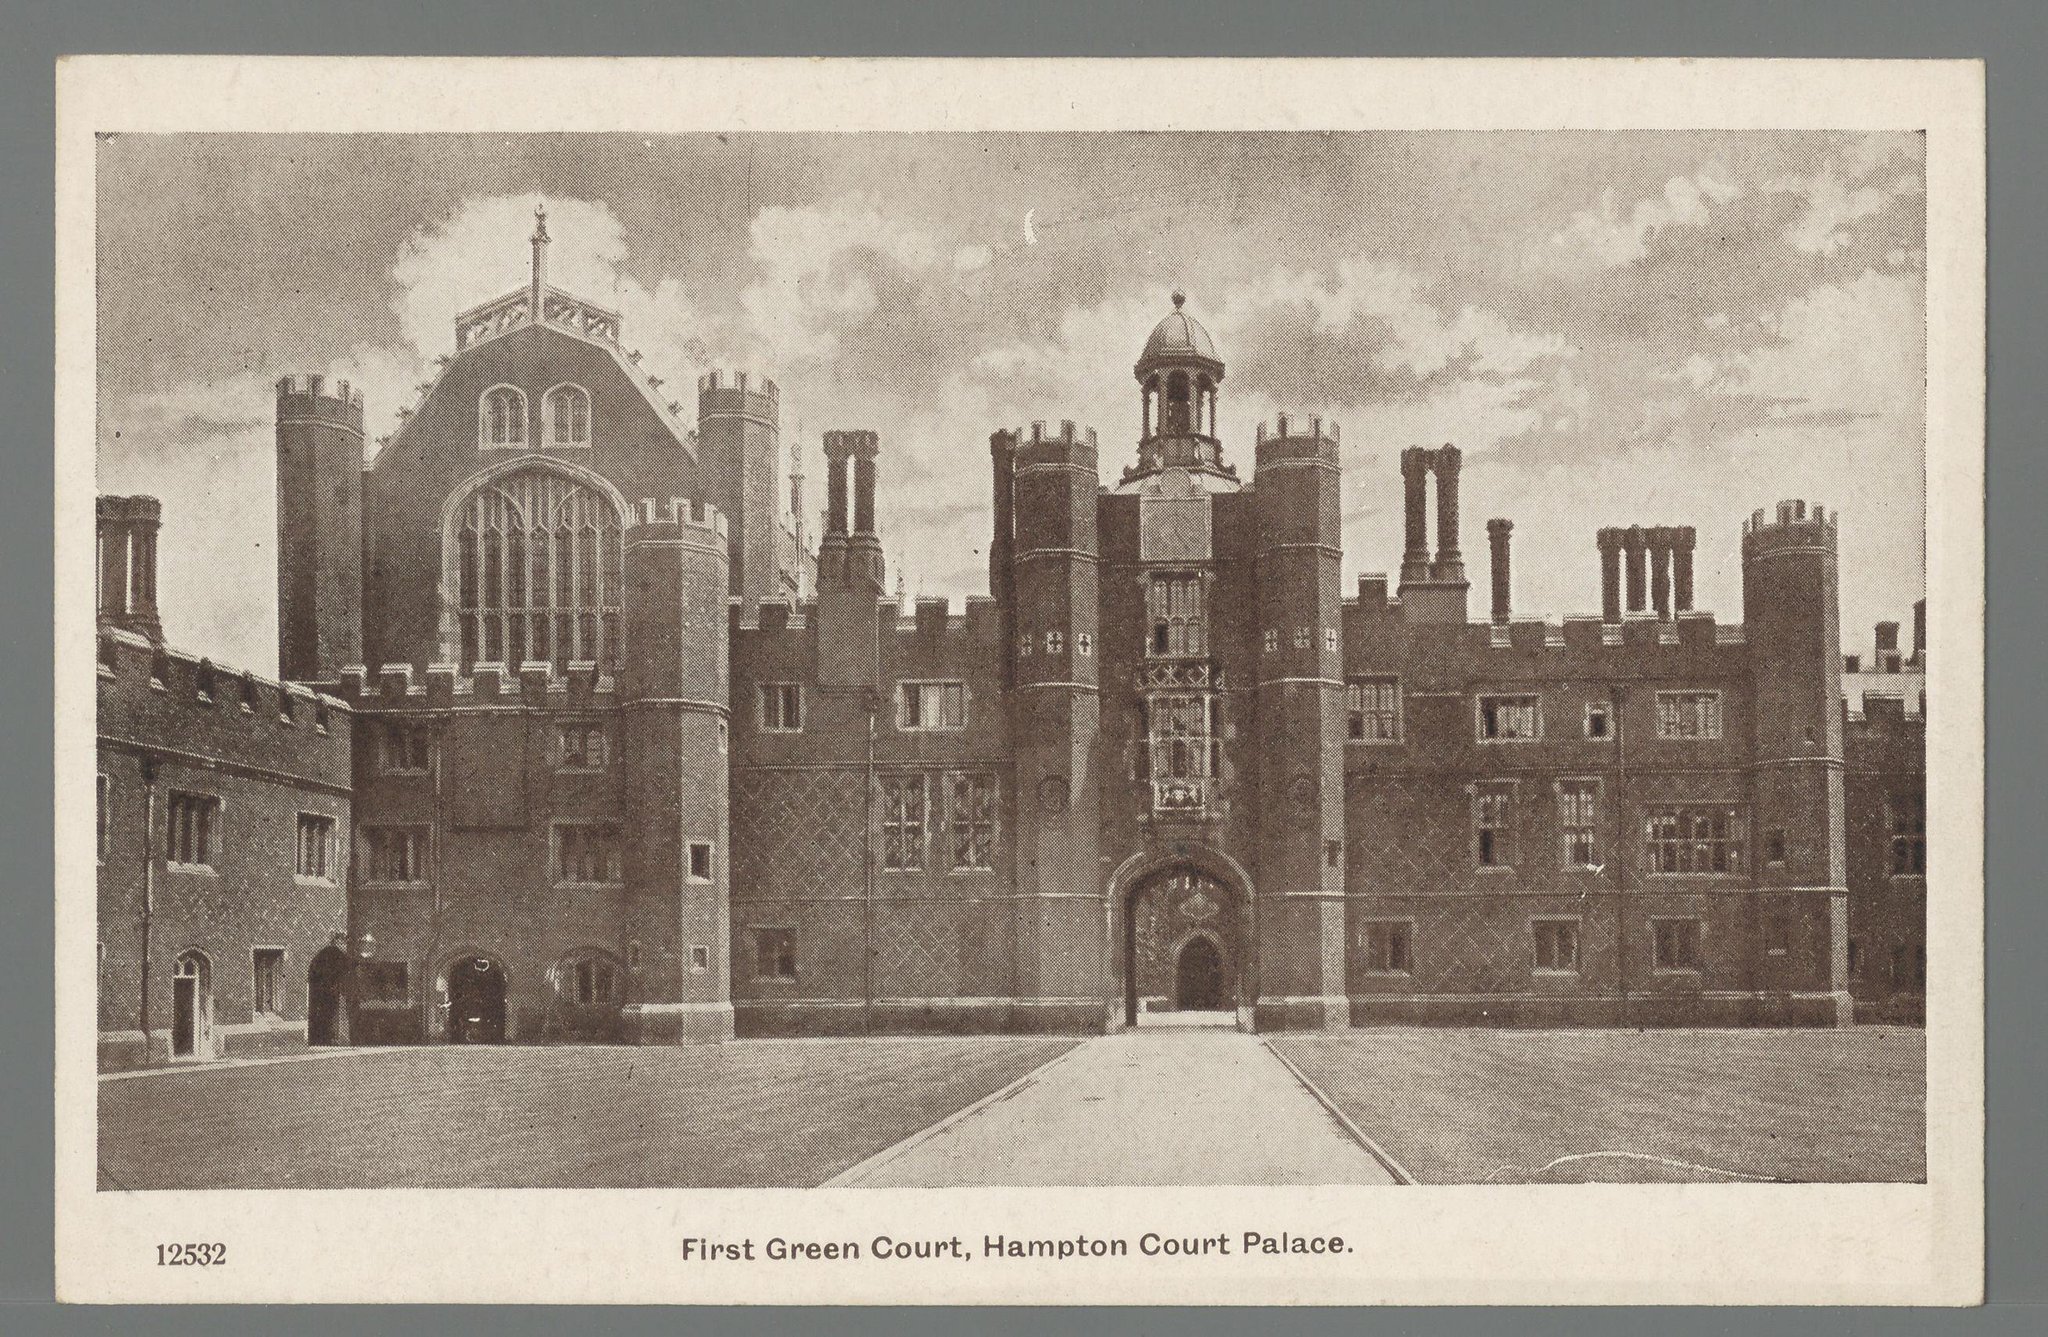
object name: photomechanical print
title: The G&P Series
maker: Anonymous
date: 1915-1930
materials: cardboard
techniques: autotype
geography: hampton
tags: palace, gate, entrance